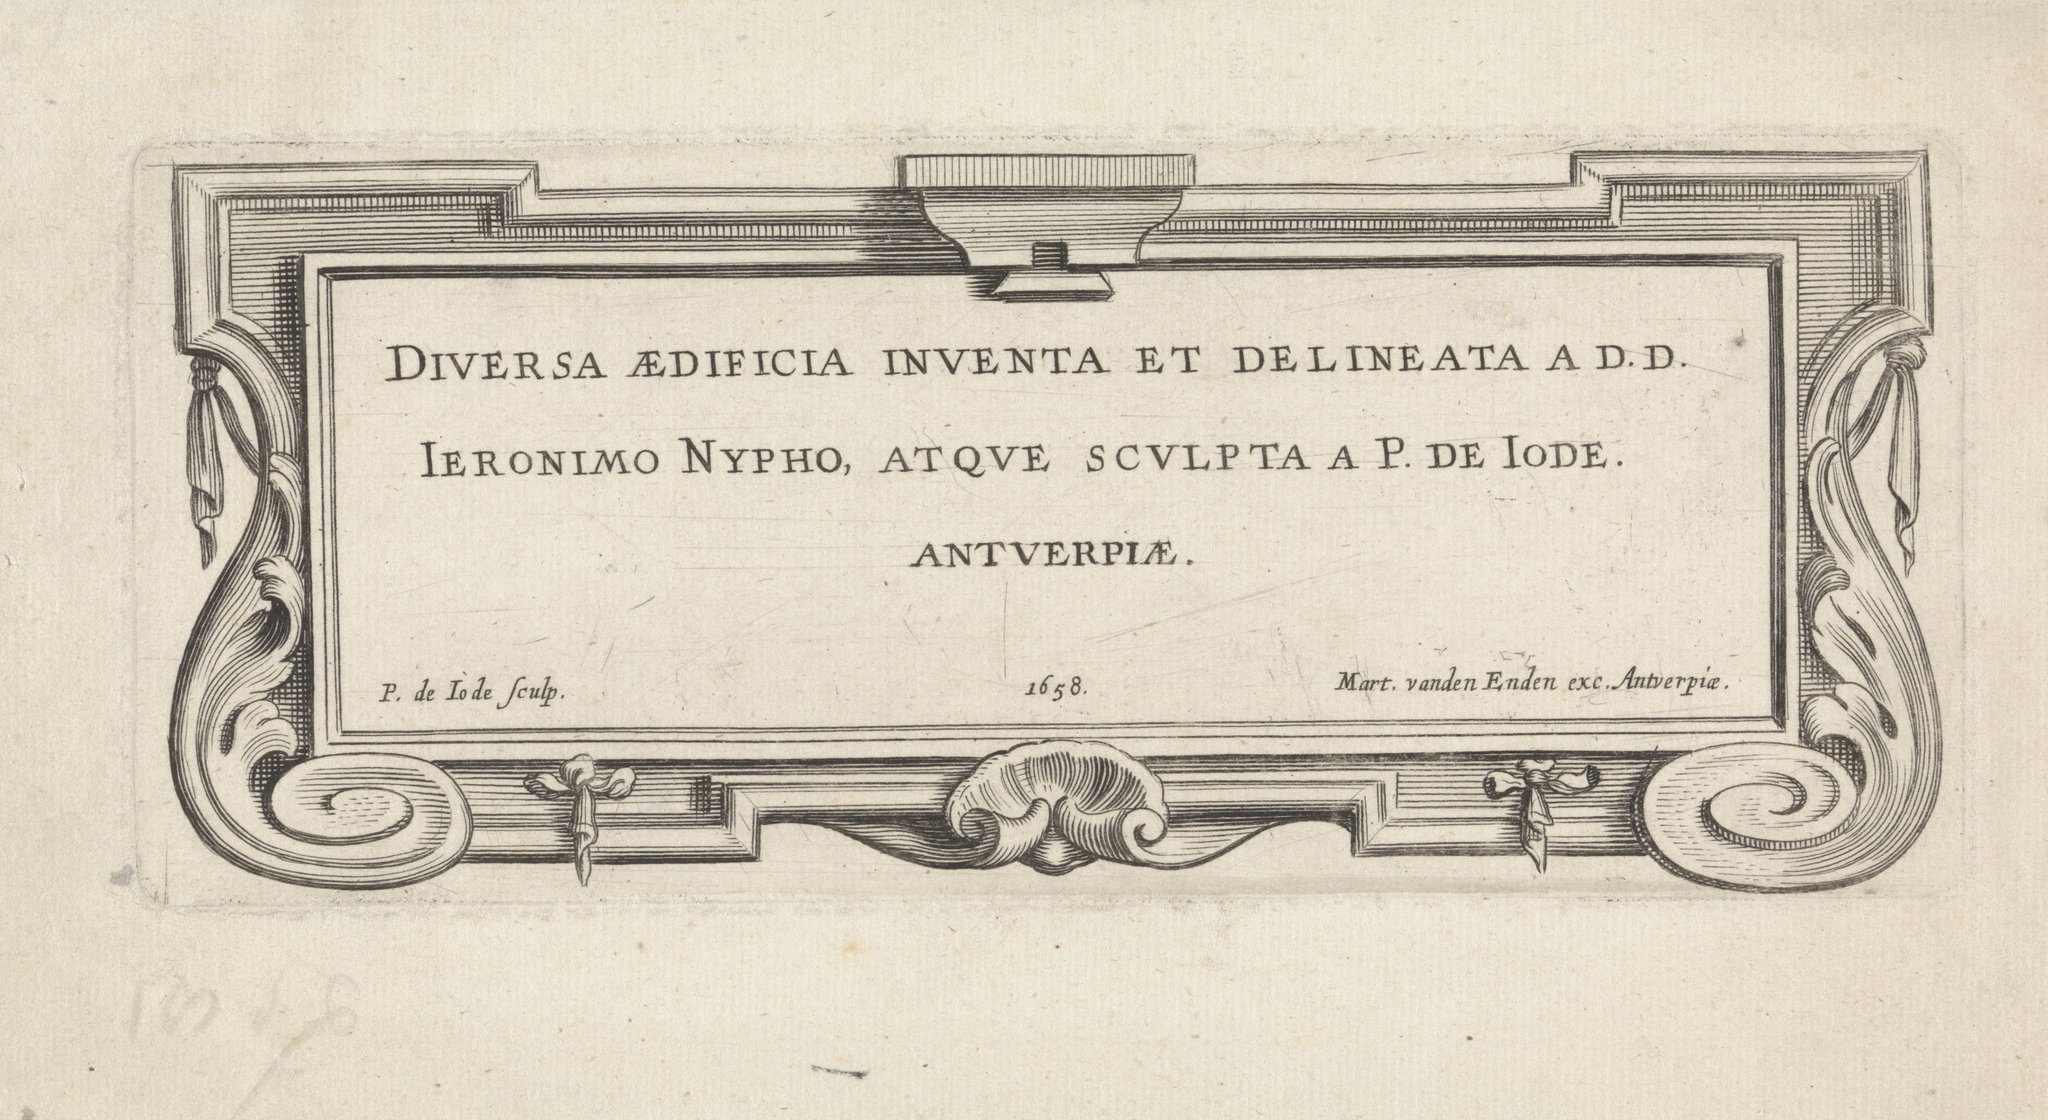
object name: titelblad, titelpagina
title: Titelpagina voor: Diversa Aedificia, 1658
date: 1658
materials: paper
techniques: engraving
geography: antwerp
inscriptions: collector's mark: Lugt 2228, inscription: ‘188’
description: Gedecoreerd kader met titel in het Latijn.